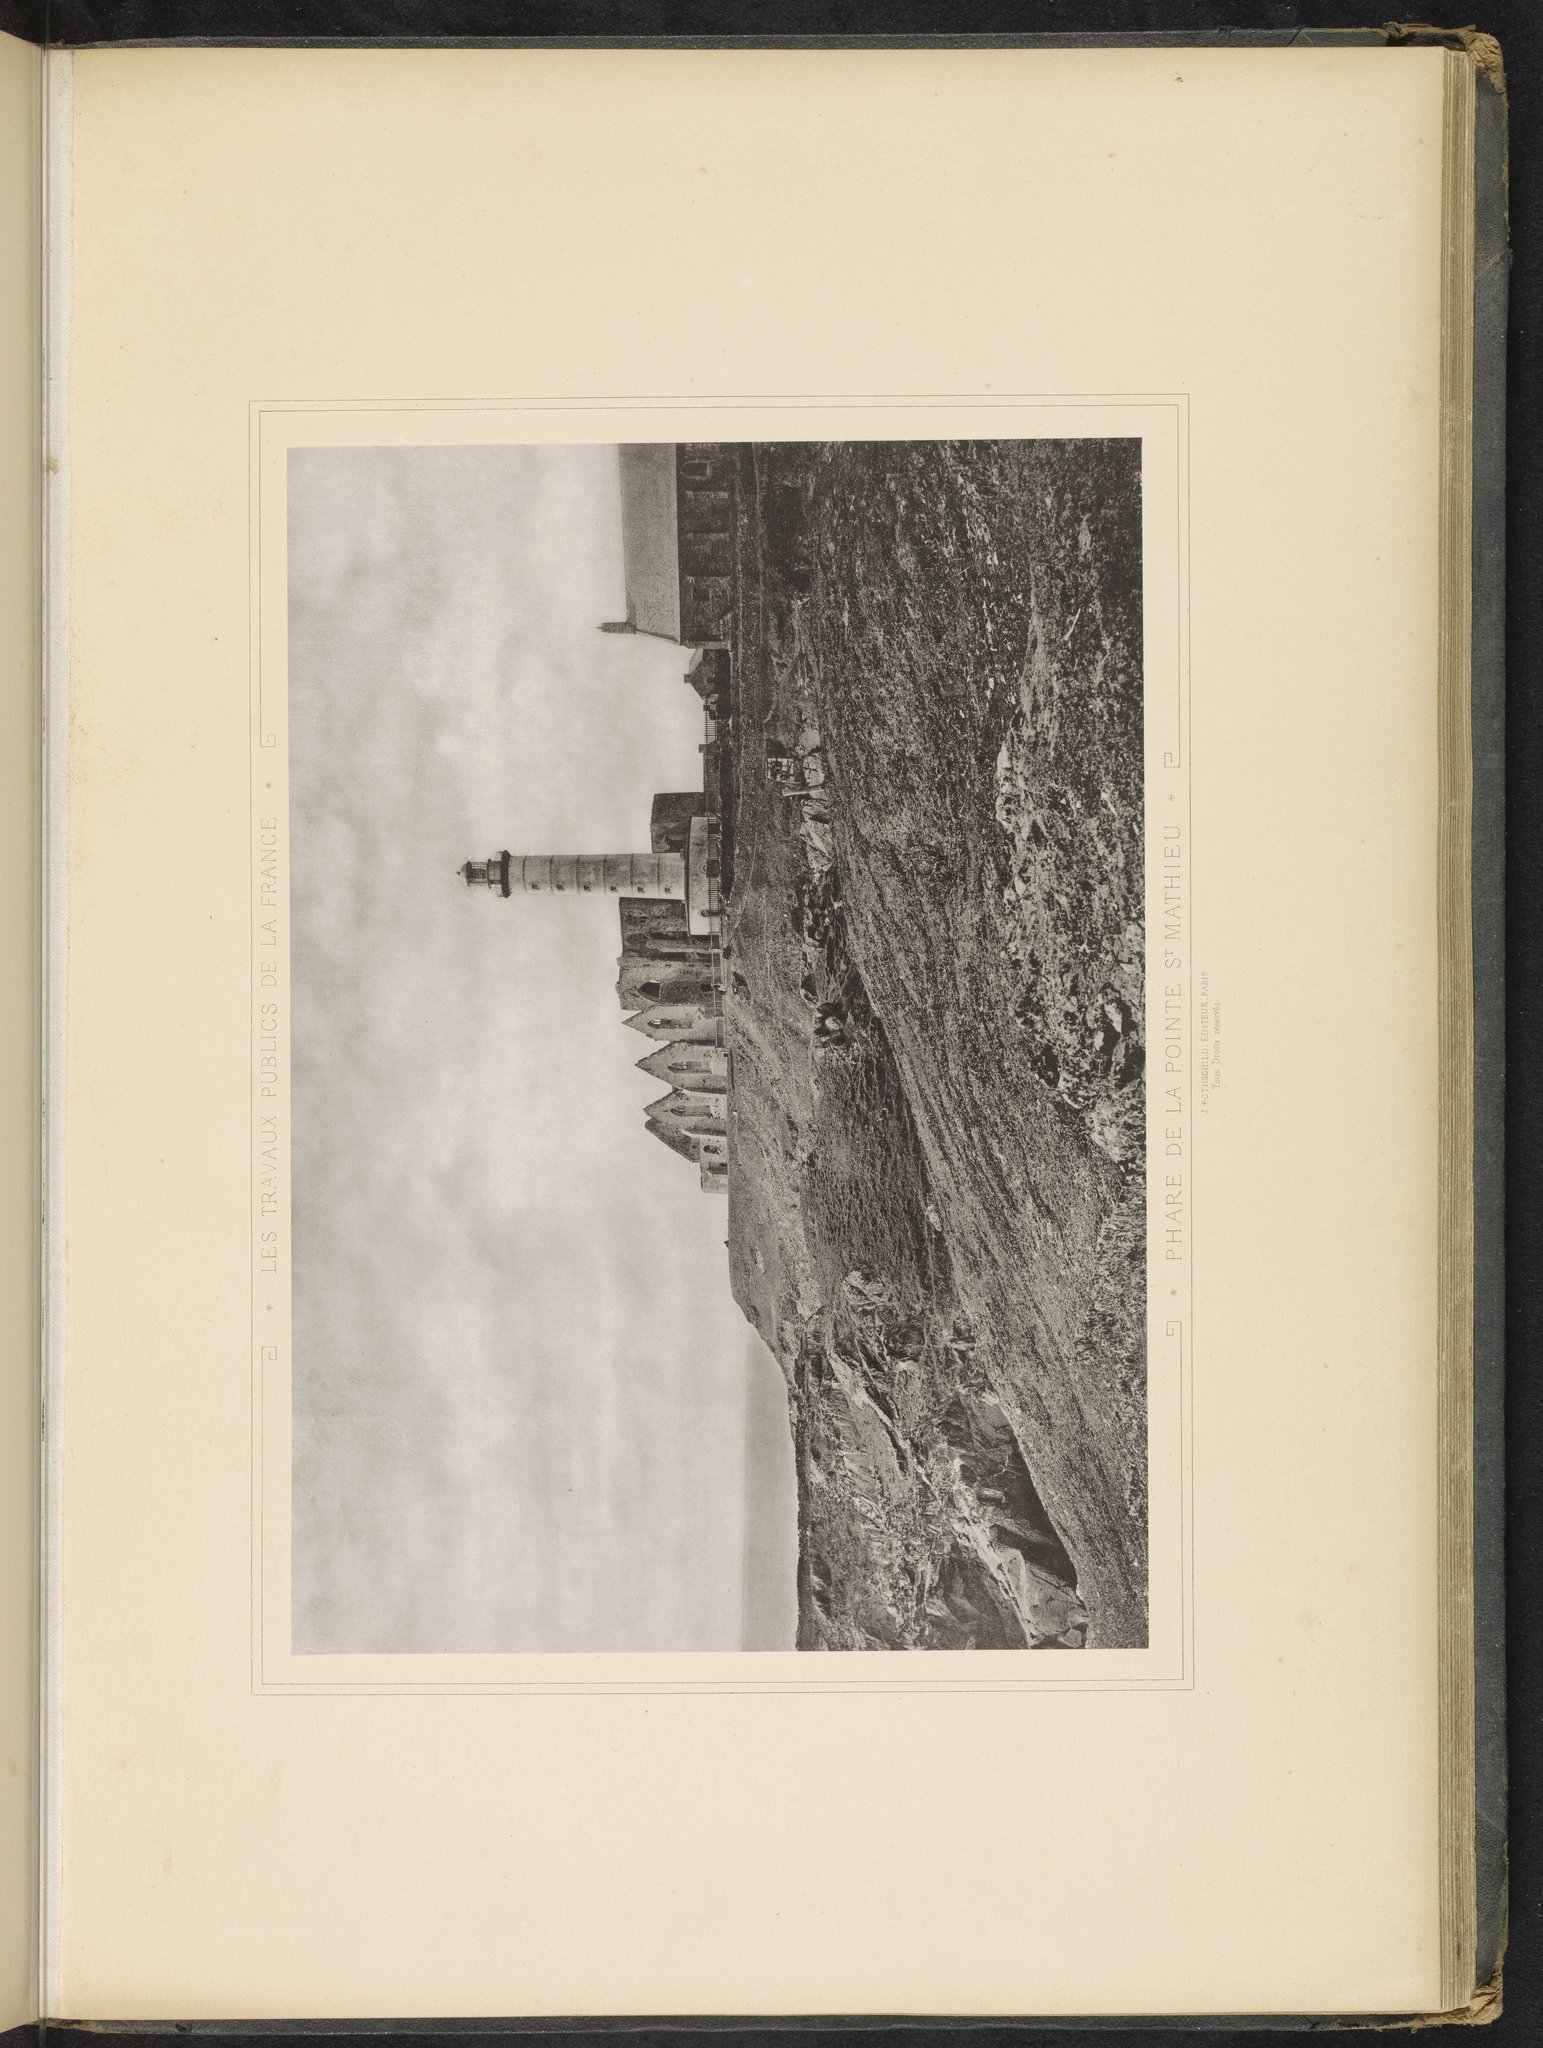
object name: page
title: Vuurtoren van Pointe Saint-Mathieu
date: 1873-1883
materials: paper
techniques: photograph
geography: paris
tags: lighthouse, lightship, rocky coast